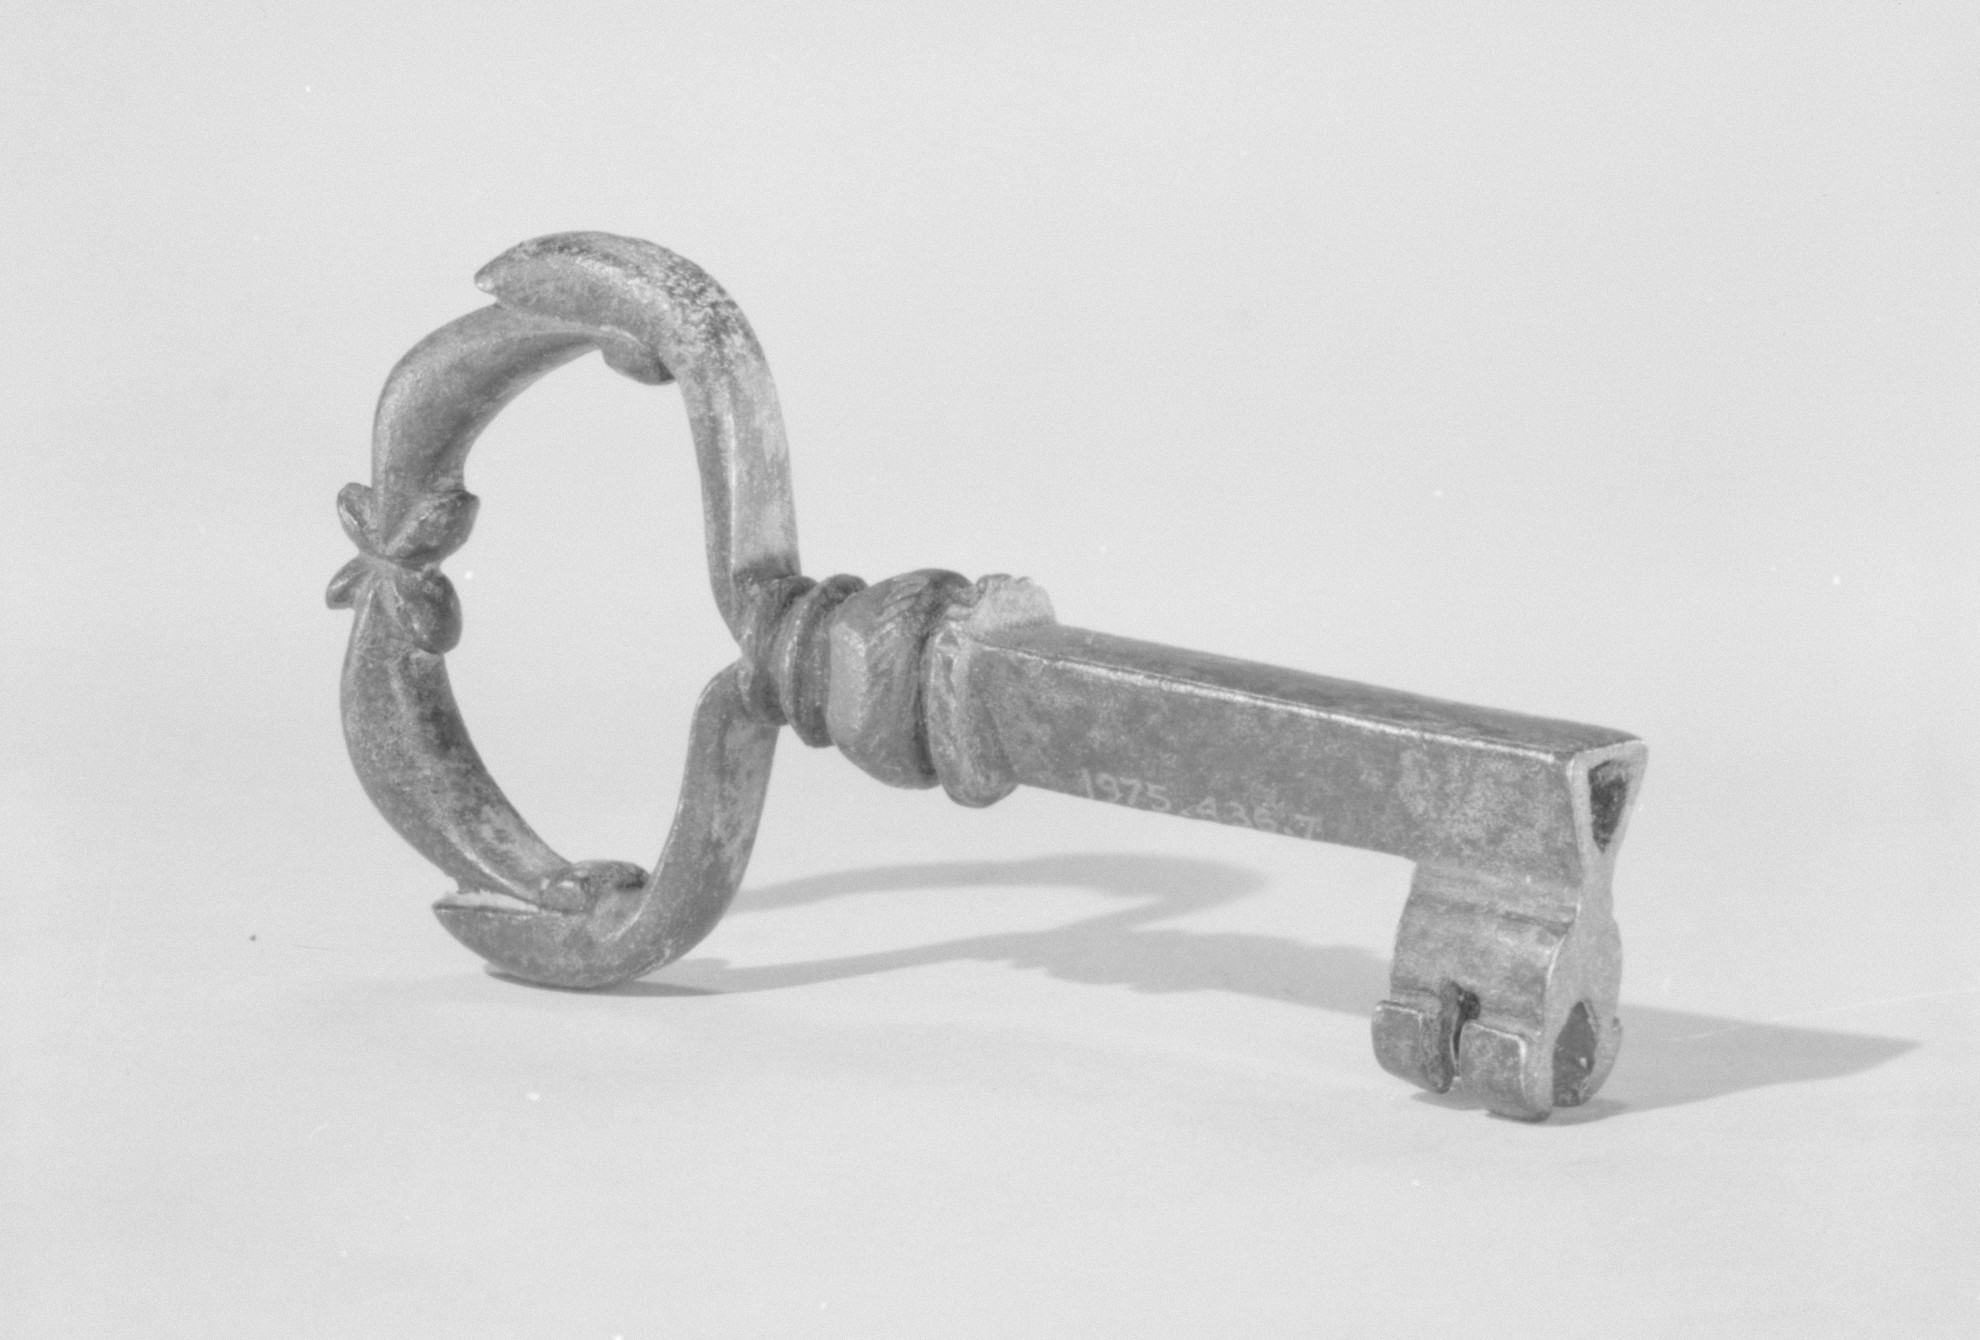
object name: coffer or chest key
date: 1601-1800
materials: iron